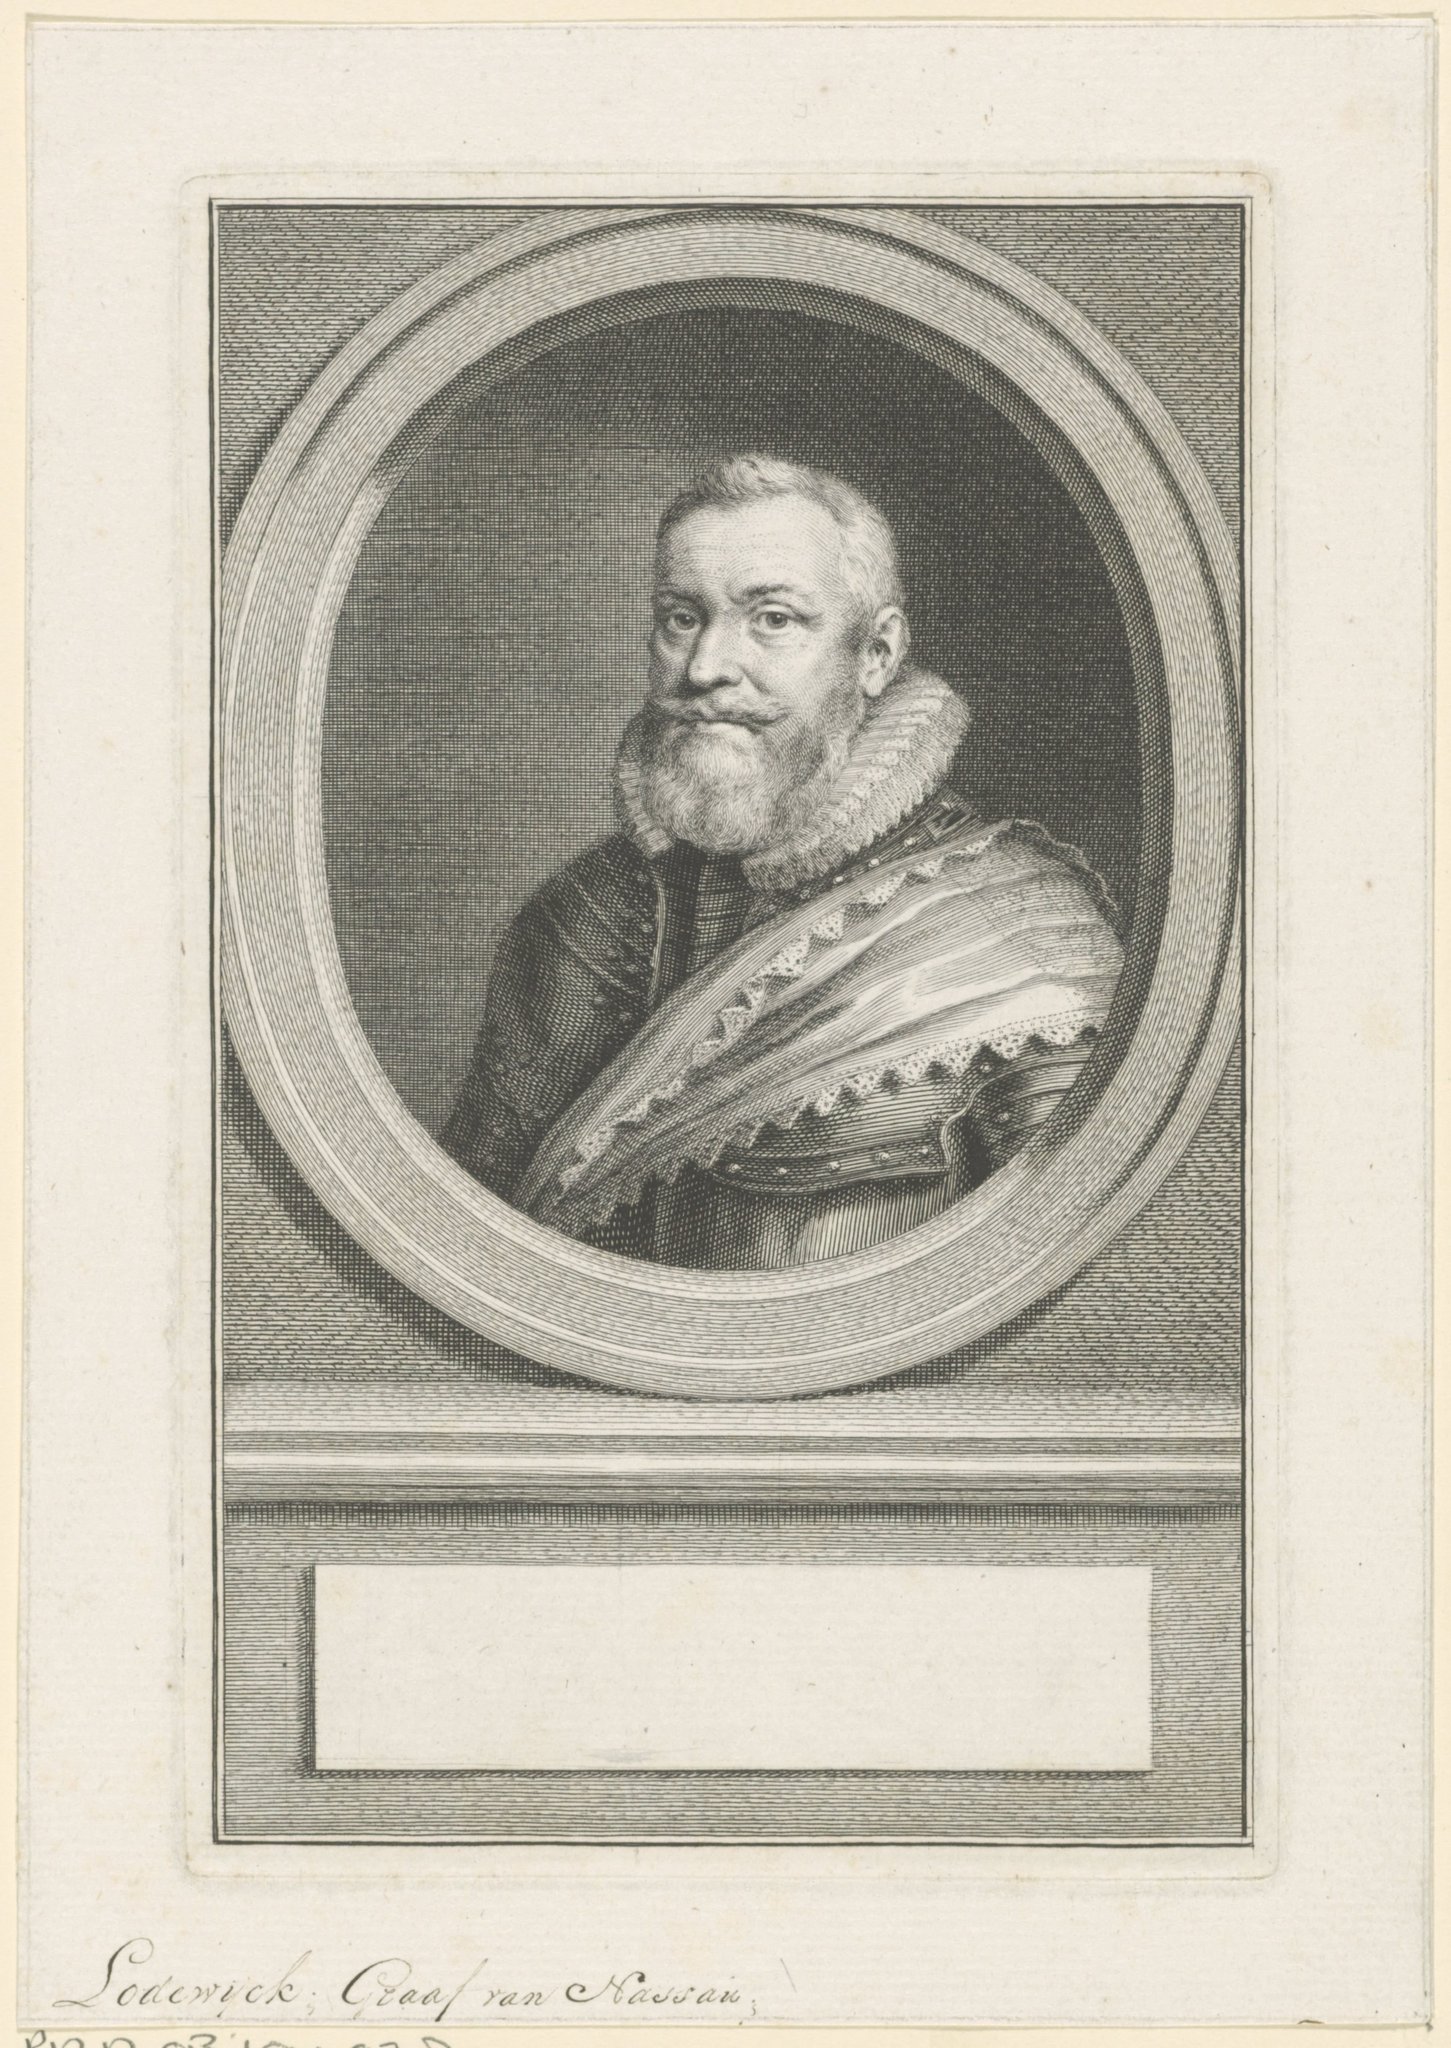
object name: print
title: Portret van Willem Lodewijk, graaf van Nassau-Dillenburg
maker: jacob houbraken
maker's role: draughtsman, print maker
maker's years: 1698-1780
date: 1749-1759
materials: paper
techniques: engraving, etching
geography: amsterdam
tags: willem lodewijk graaf van nassau-dillenburg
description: De hier vermelde titel verwijst naar de hoogst verkregen titel van de geportretteerde, niet per se naar de titel die de geportretteerde op deze voorstelling draagt.